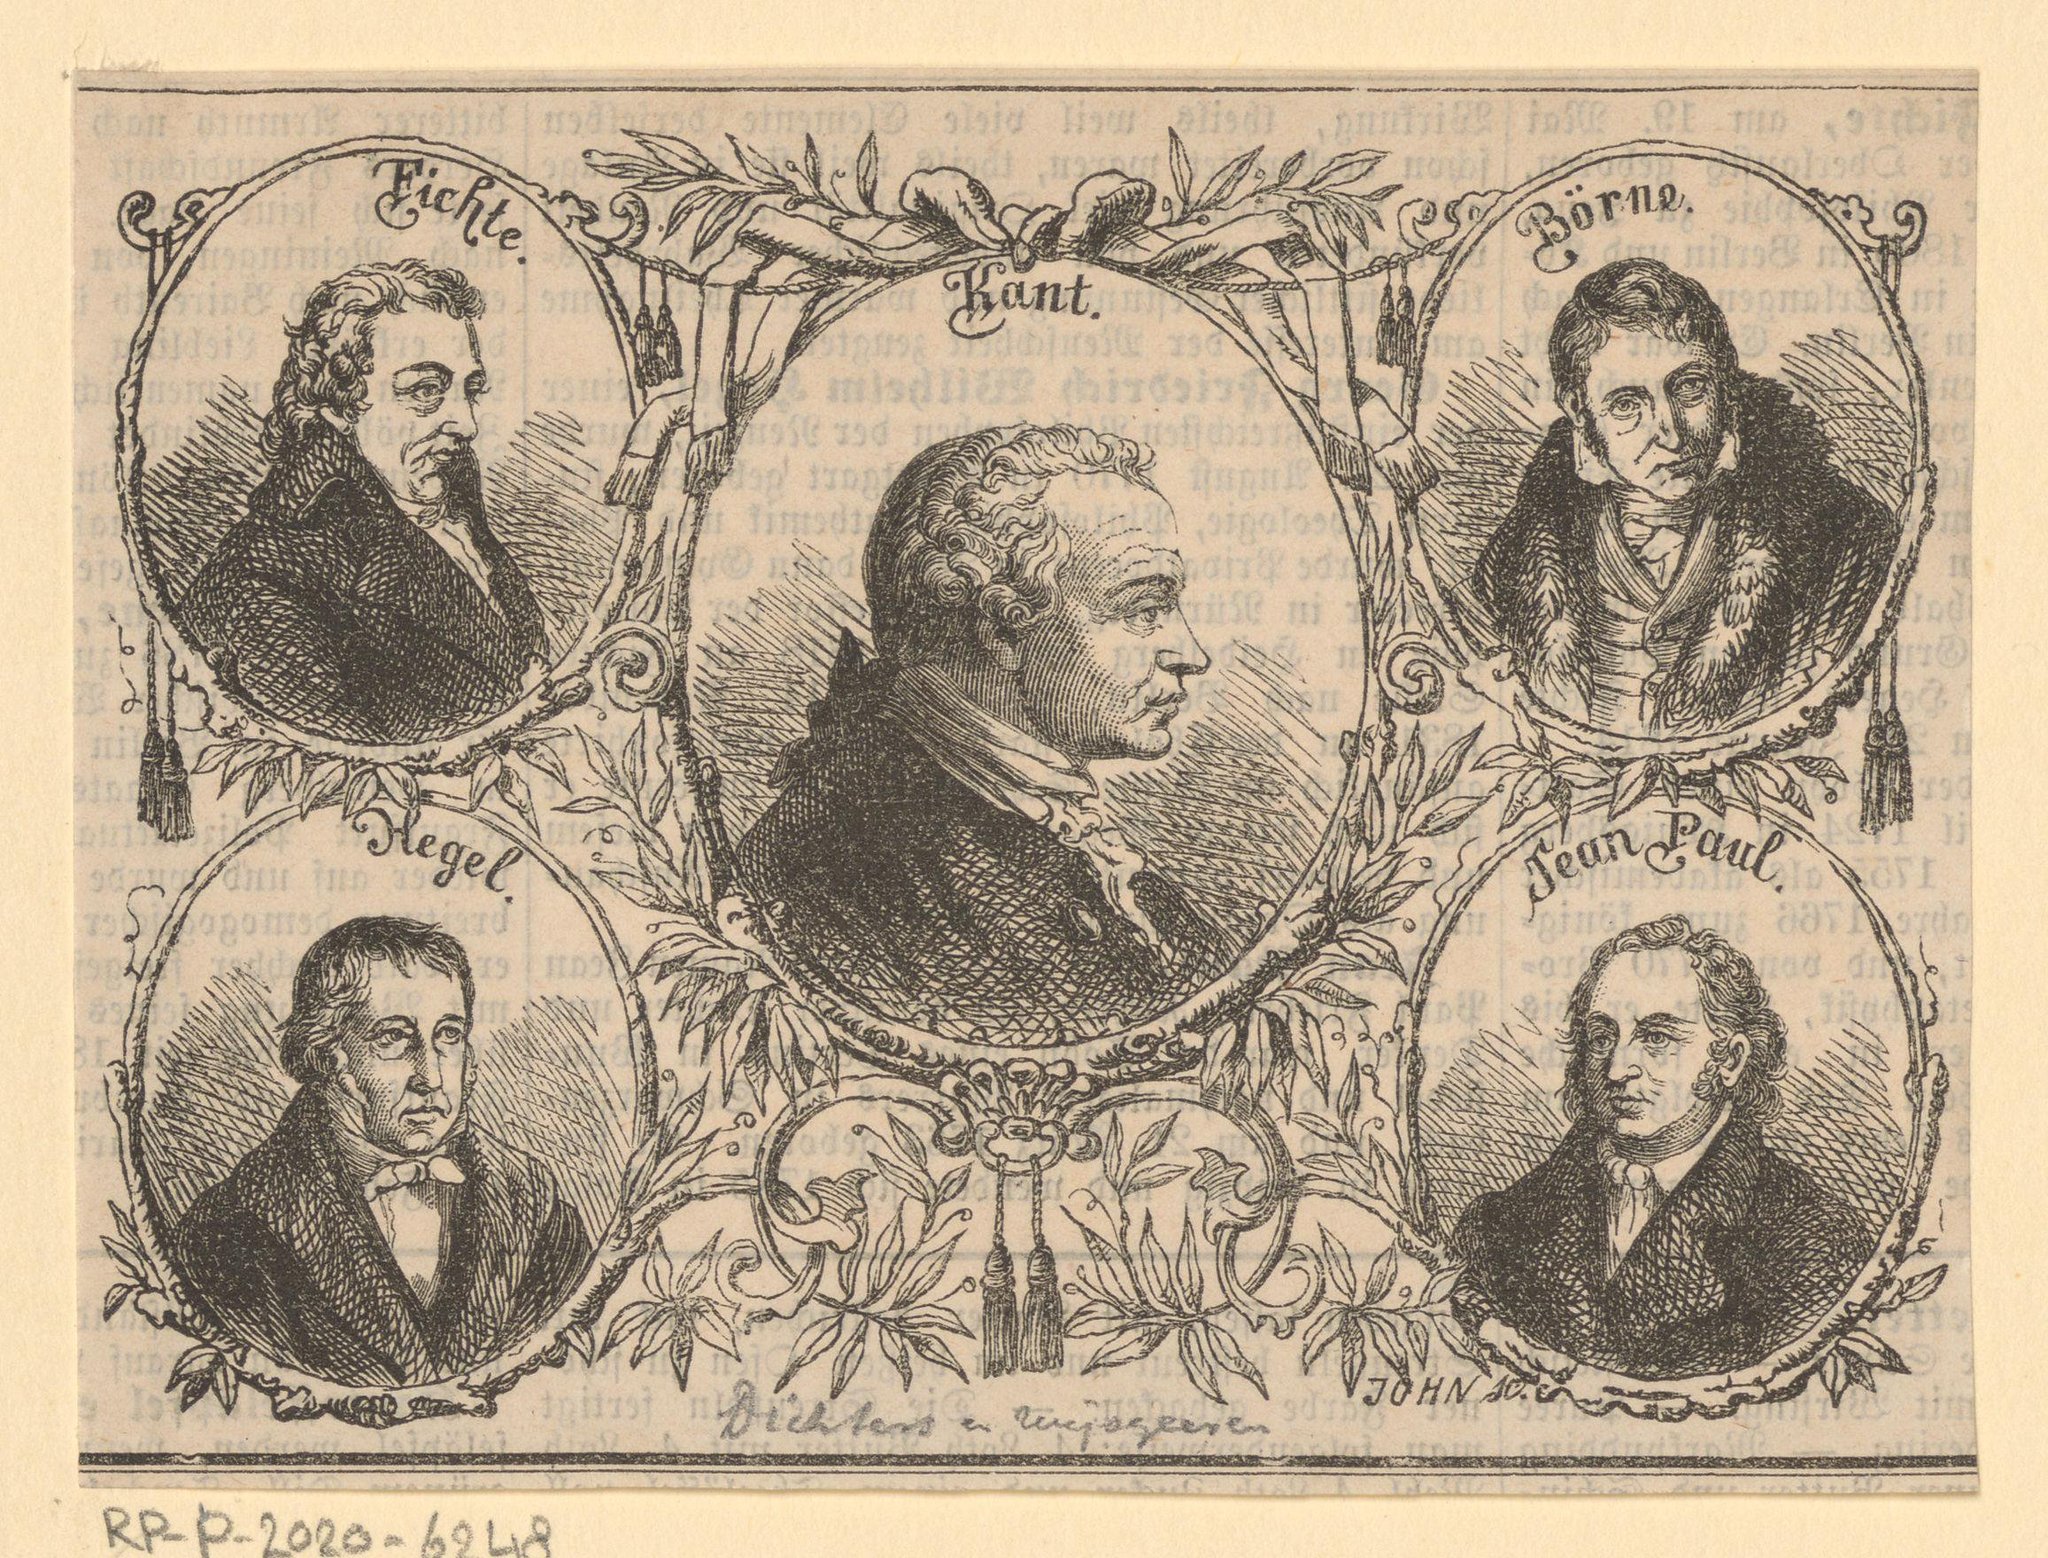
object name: print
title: Portret van Immanuel Kant, Georg Wilhelm Friedrich Hegel, Jean Paul Richter, Ludwig Börne en Johann Gottlieb Fichte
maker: john jackson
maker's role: print maker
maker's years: 1801-1848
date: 1791-1837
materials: paper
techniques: letterpress printing, engraving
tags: paris, berlin, historical persons, scholar, philosopher (+ portrait of scholar, scientist)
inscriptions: date